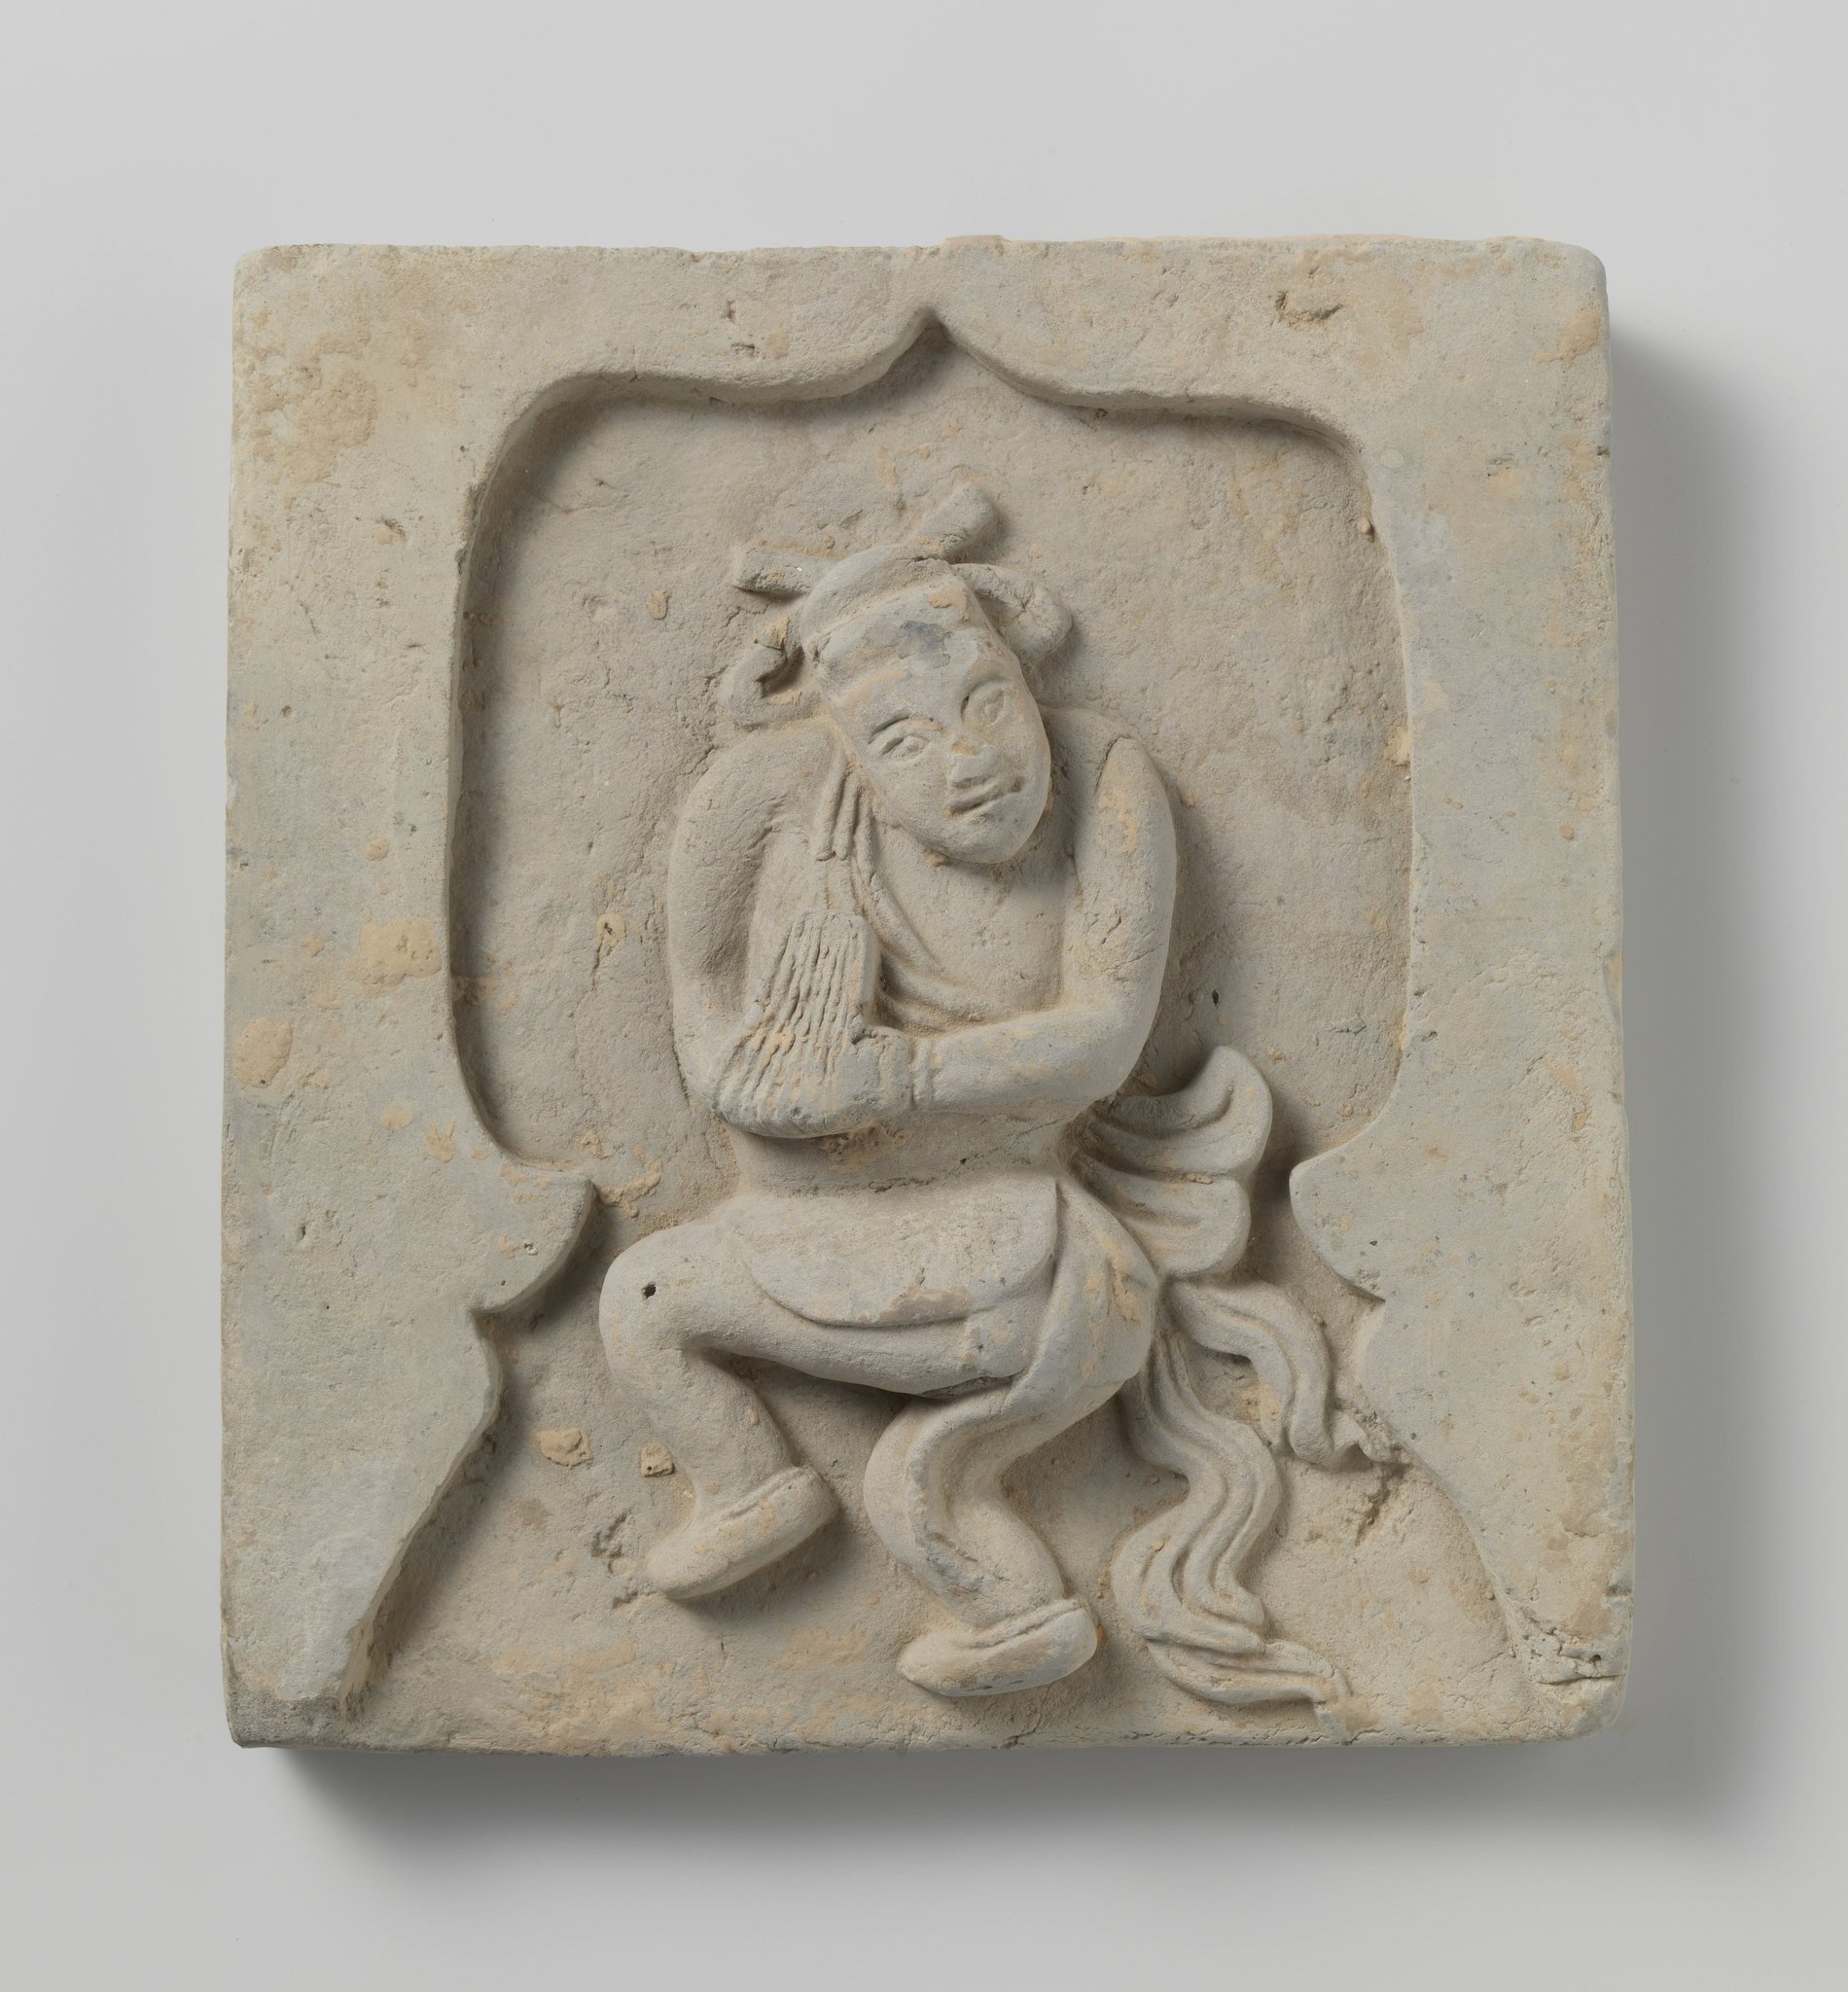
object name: tile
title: Tegel met dansende toneelspeler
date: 1100-1400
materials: stoneware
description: Dancing man with castanets. Dancing drummer. Tomb tiles. China. Yuan period (1260 - 1368), mid-13th century. Earthenware. Between c. 1100 and 1400, graves were embellished with series of these musician tiles. The tiles were produced in moulds allowing large numbers of the same kind to be made. A second example of the dancing man with castanets has been found.